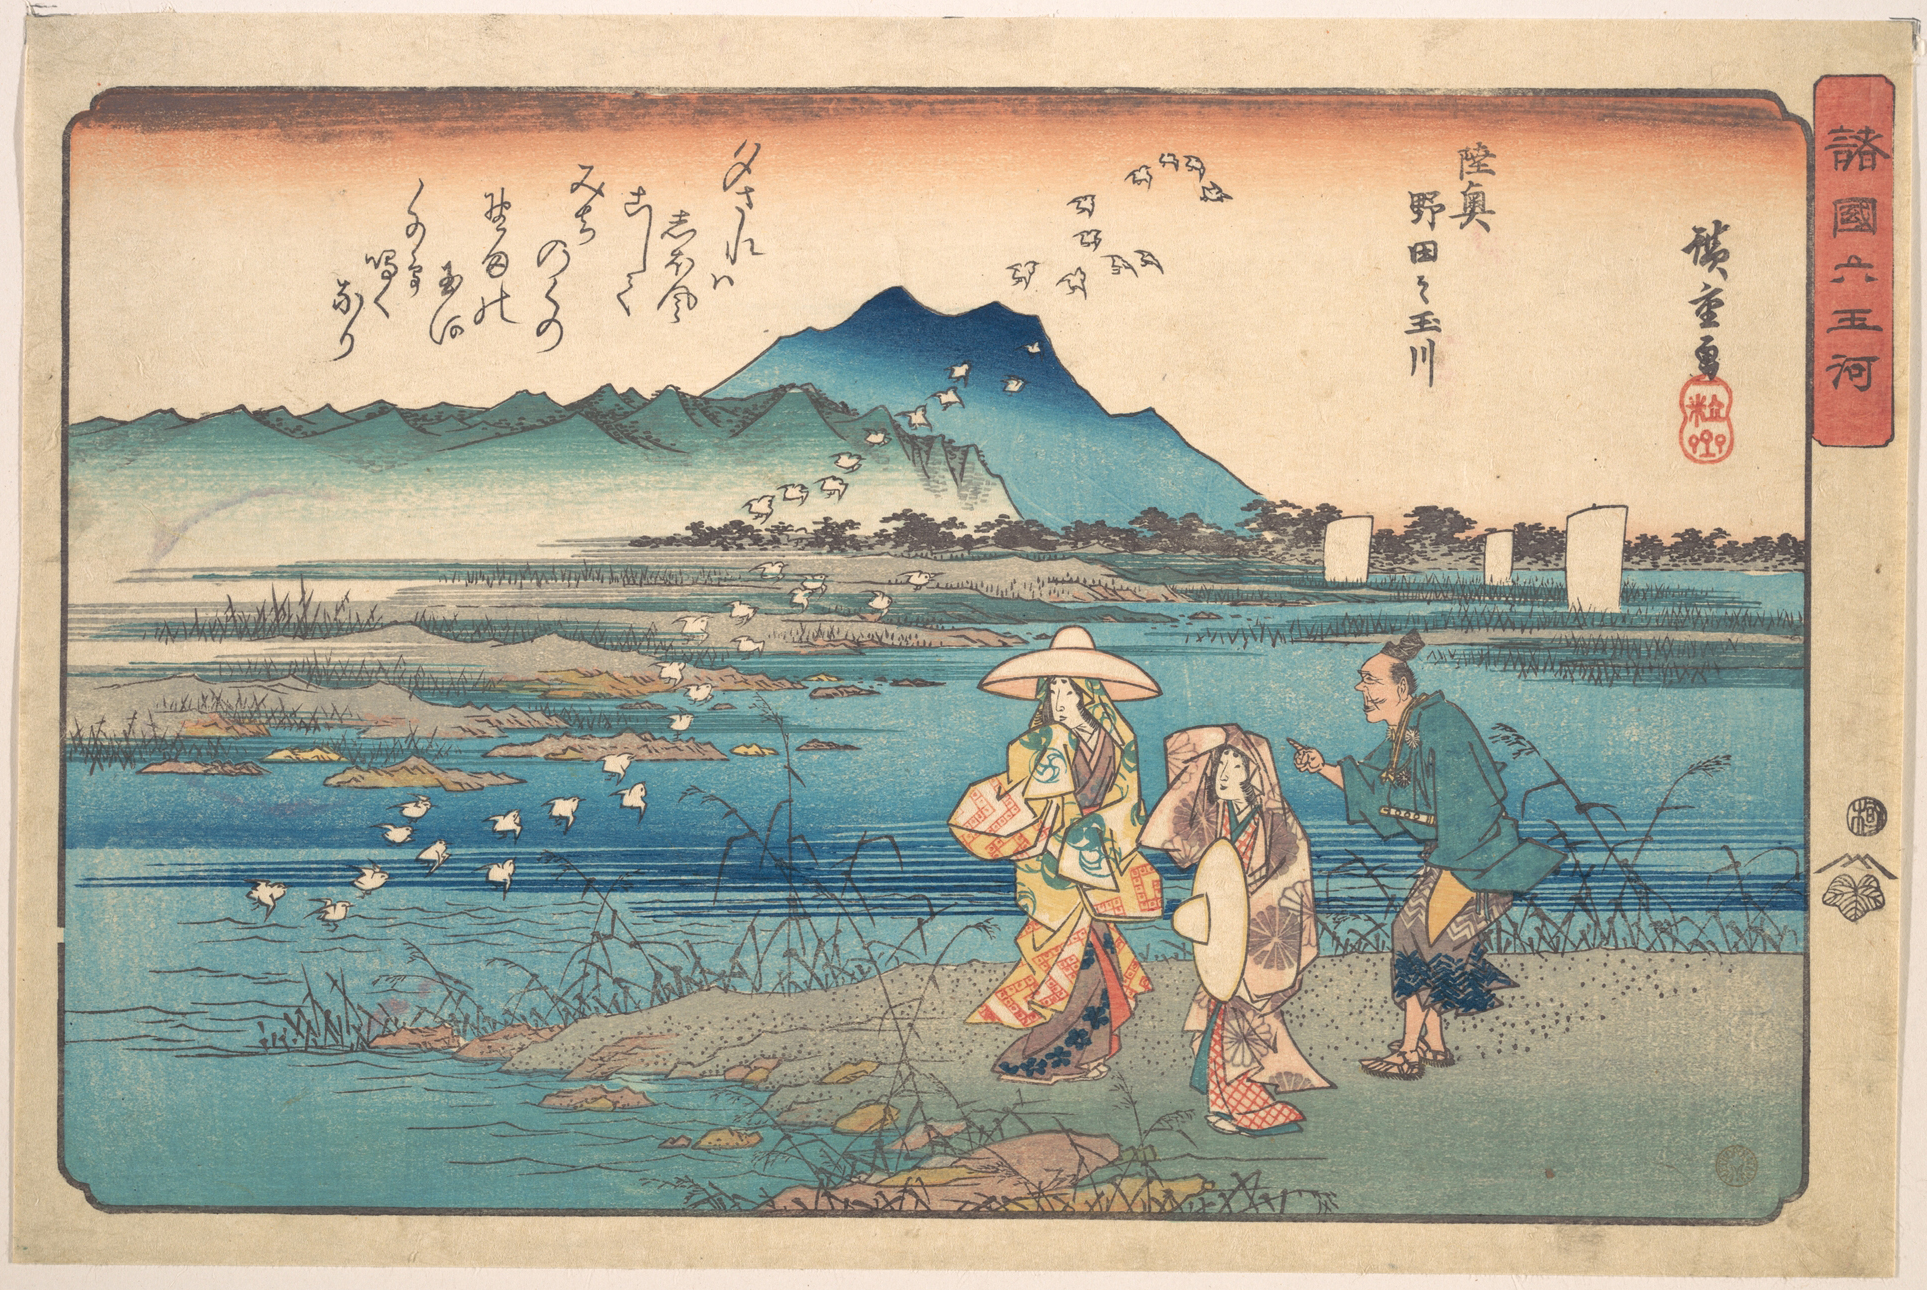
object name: print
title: Mutsu, Noda no Tamagawa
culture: japanese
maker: utagawa hiroshige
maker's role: artist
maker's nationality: japanese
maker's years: 1797-1858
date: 1833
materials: ink, paper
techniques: woodblock print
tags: men,women,rivers,mountains